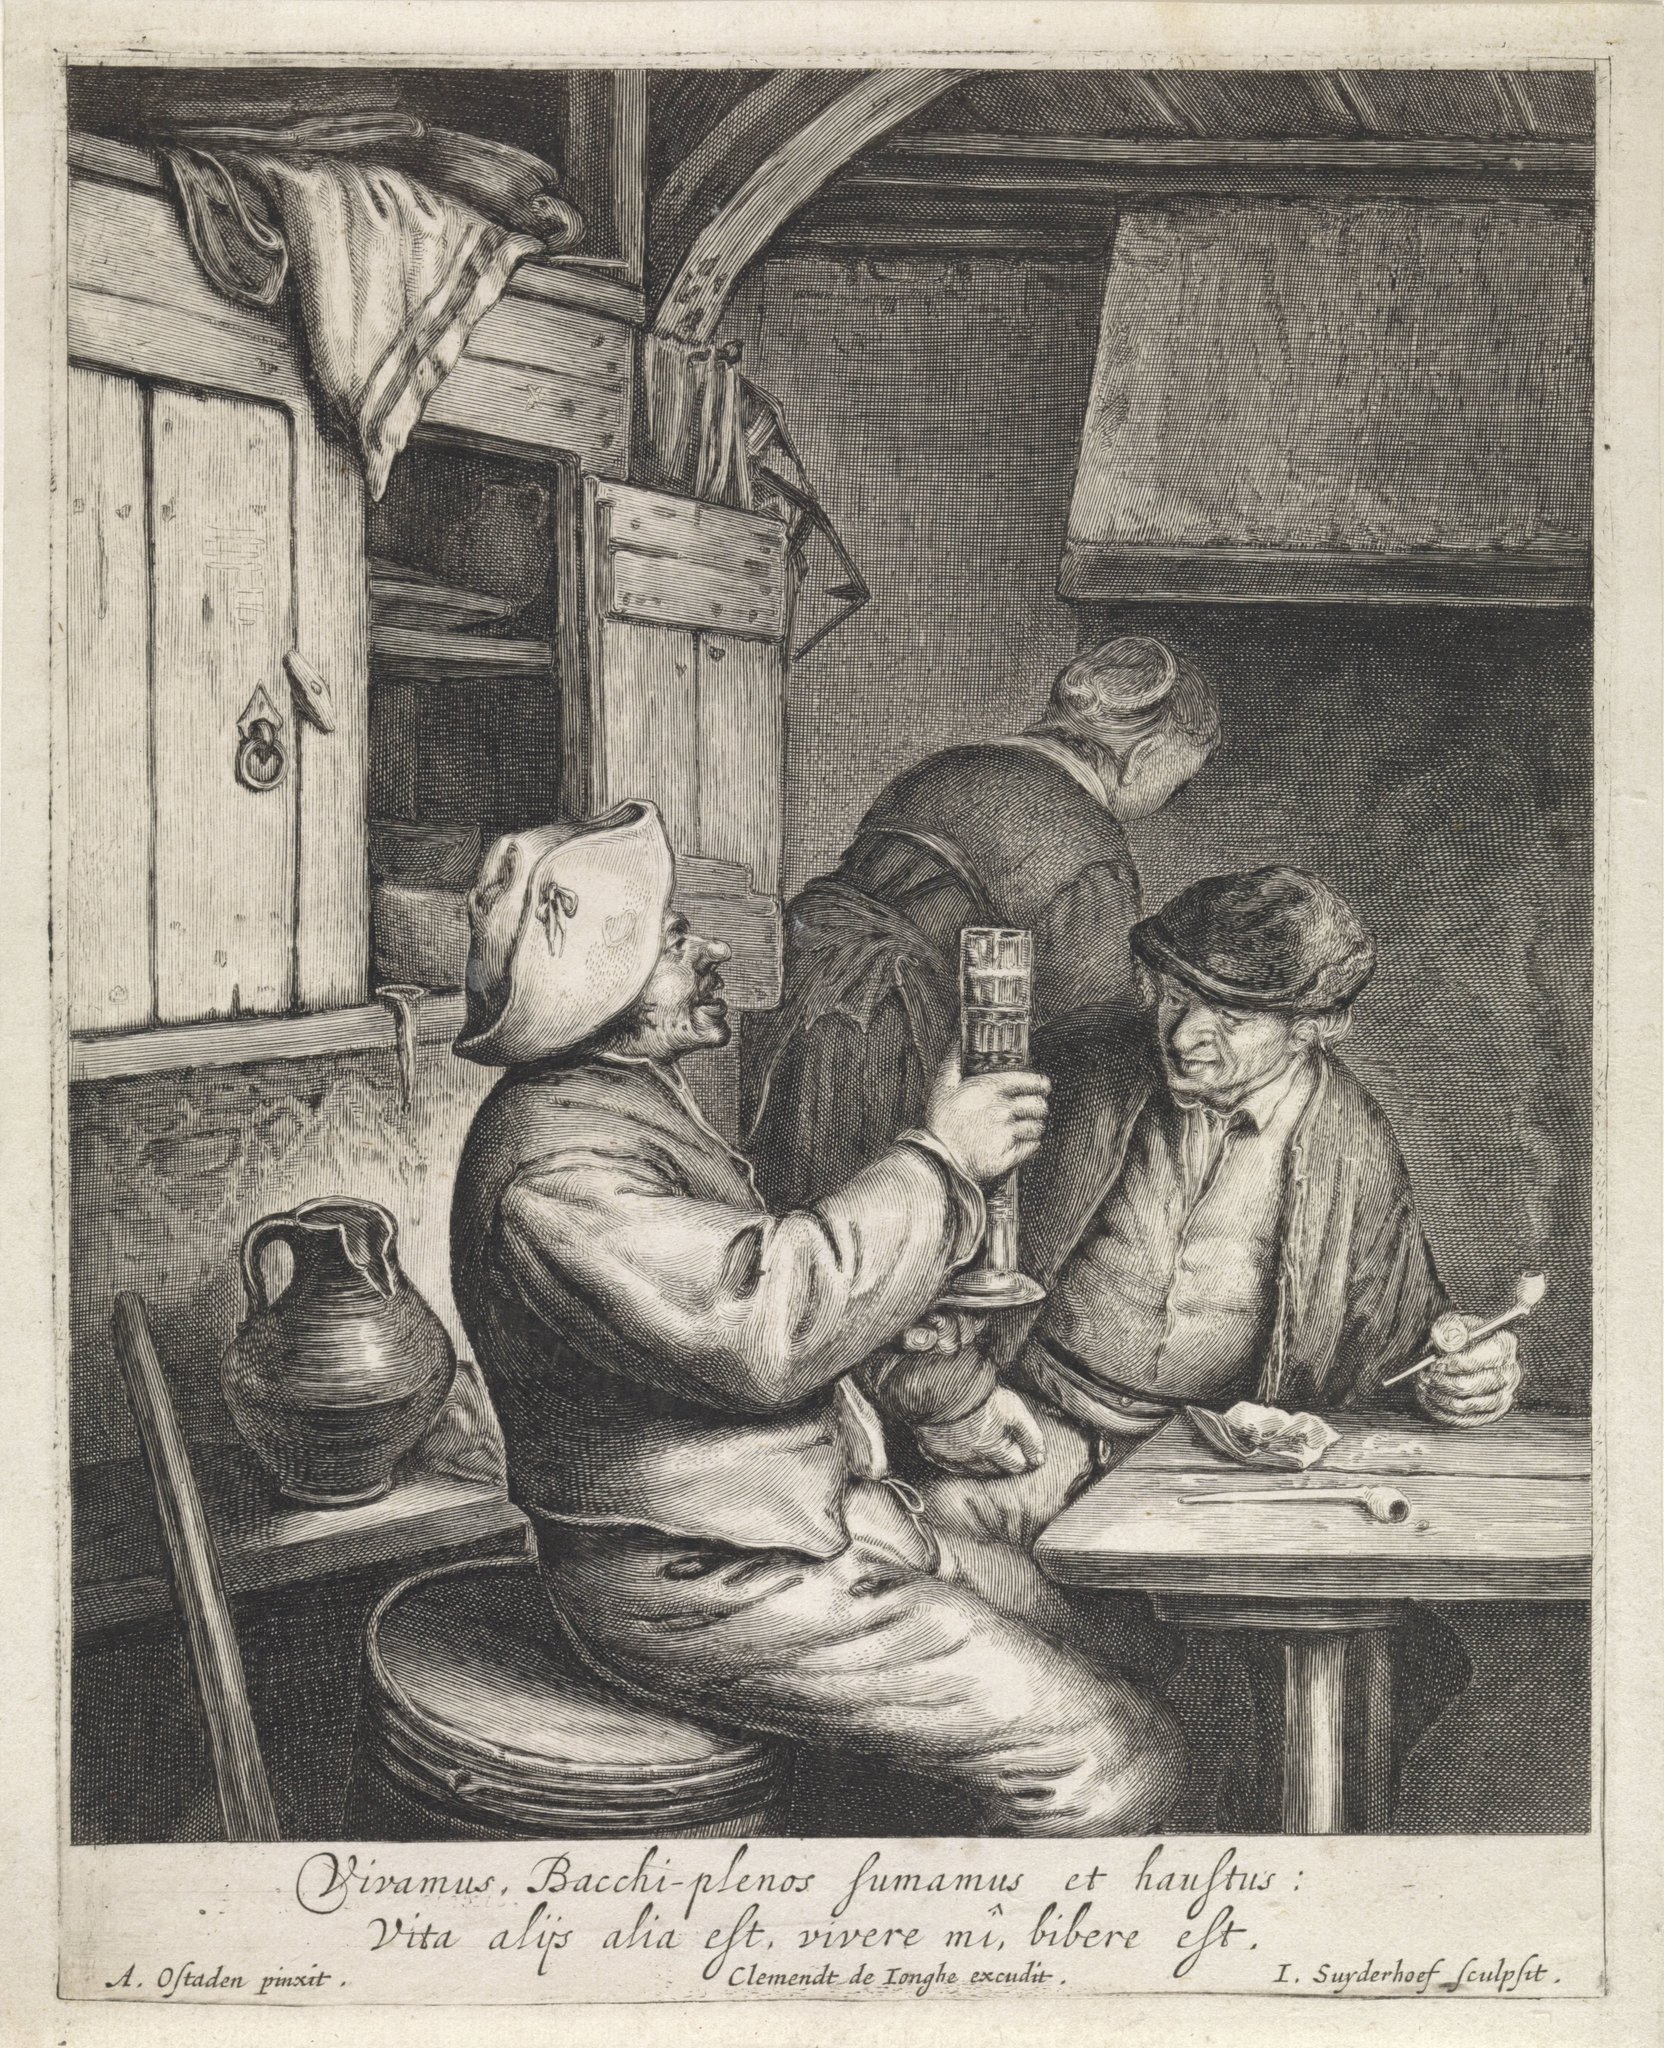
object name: print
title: Twee boeren zittend aan een tafel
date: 1643-1677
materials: paper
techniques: engraving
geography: amsterdam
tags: pipe ~ tobacco, glass, rummer, cupboard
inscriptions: collector's mark: Lugt 240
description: Twee boeren zitten aan een tafel. De een heft een glas, de ander houdt een pijp in de hand. Op de achtergrond een vrouw op de rug gezien.